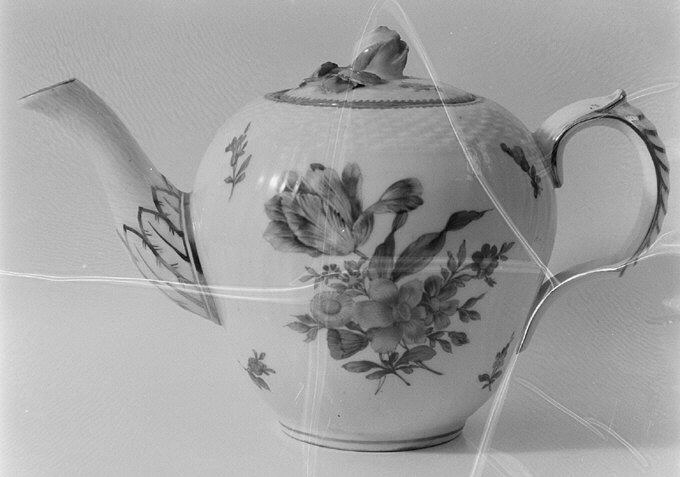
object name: teapot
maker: royal porcelain manufactory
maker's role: factory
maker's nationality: danish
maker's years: 1775-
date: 1801-1900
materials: hard paste porcelain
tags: flowers